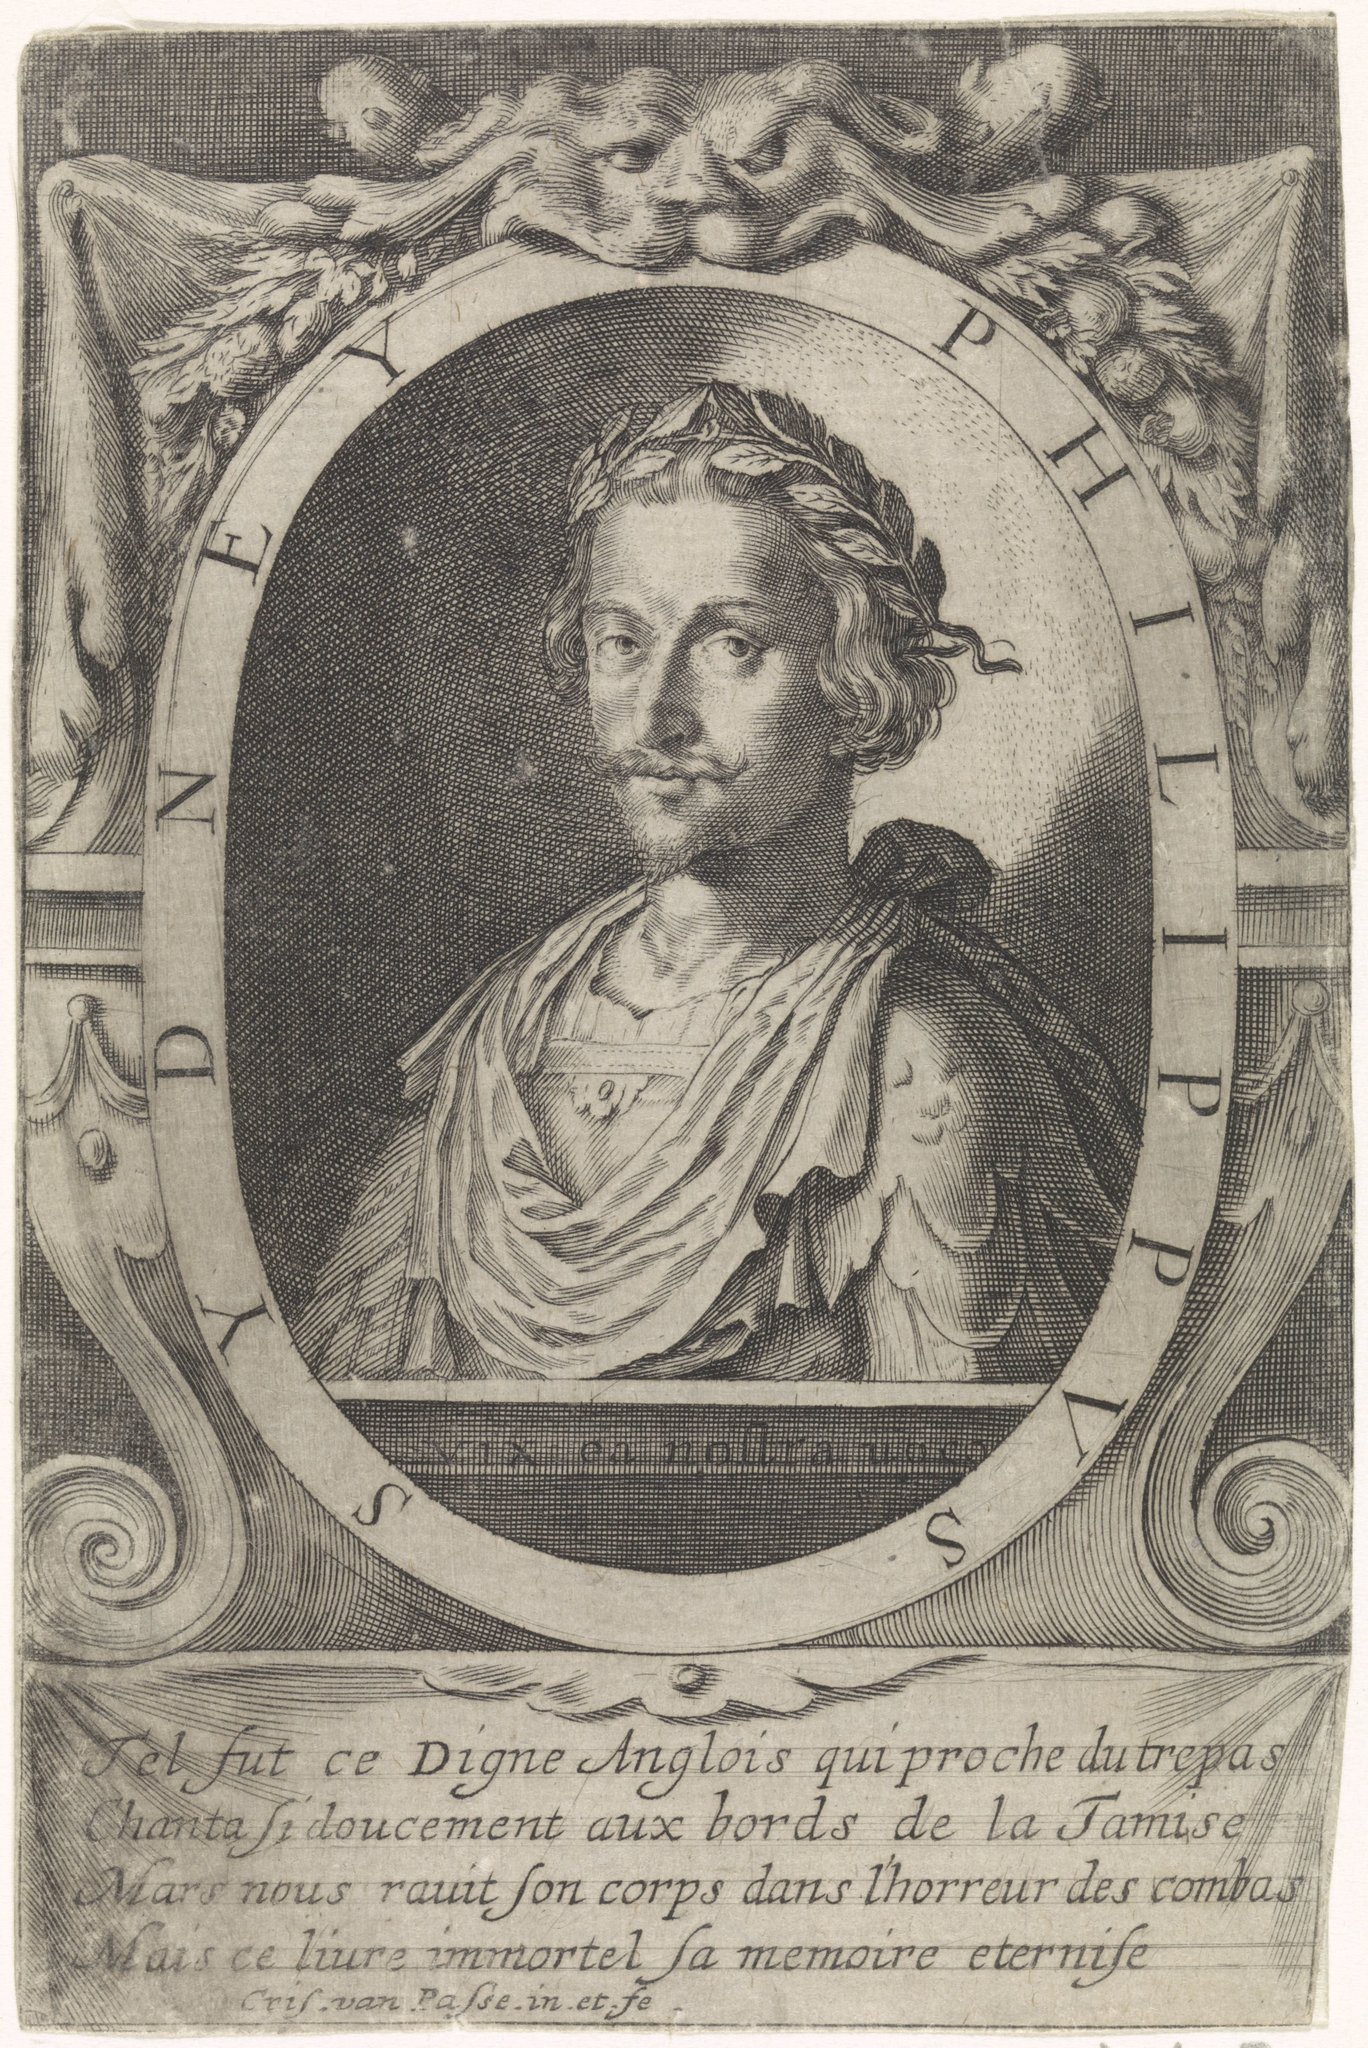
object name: print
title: Portret van Philip Sydney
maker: crispijn van de passe (i)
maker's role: draughtsman, print maker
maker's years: 1564-1637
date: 1574-1637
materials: paper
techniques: engraving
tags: philip sydney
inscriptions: collector's mark: Lugt 2760, collector's mark: Lugt 2228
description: Portret van Philip Sydney, Engelse dichter, hoveling en soldaat, eronder zijn devies in het Latijn. In de marge een vierregelig lofdicht in het Frans.